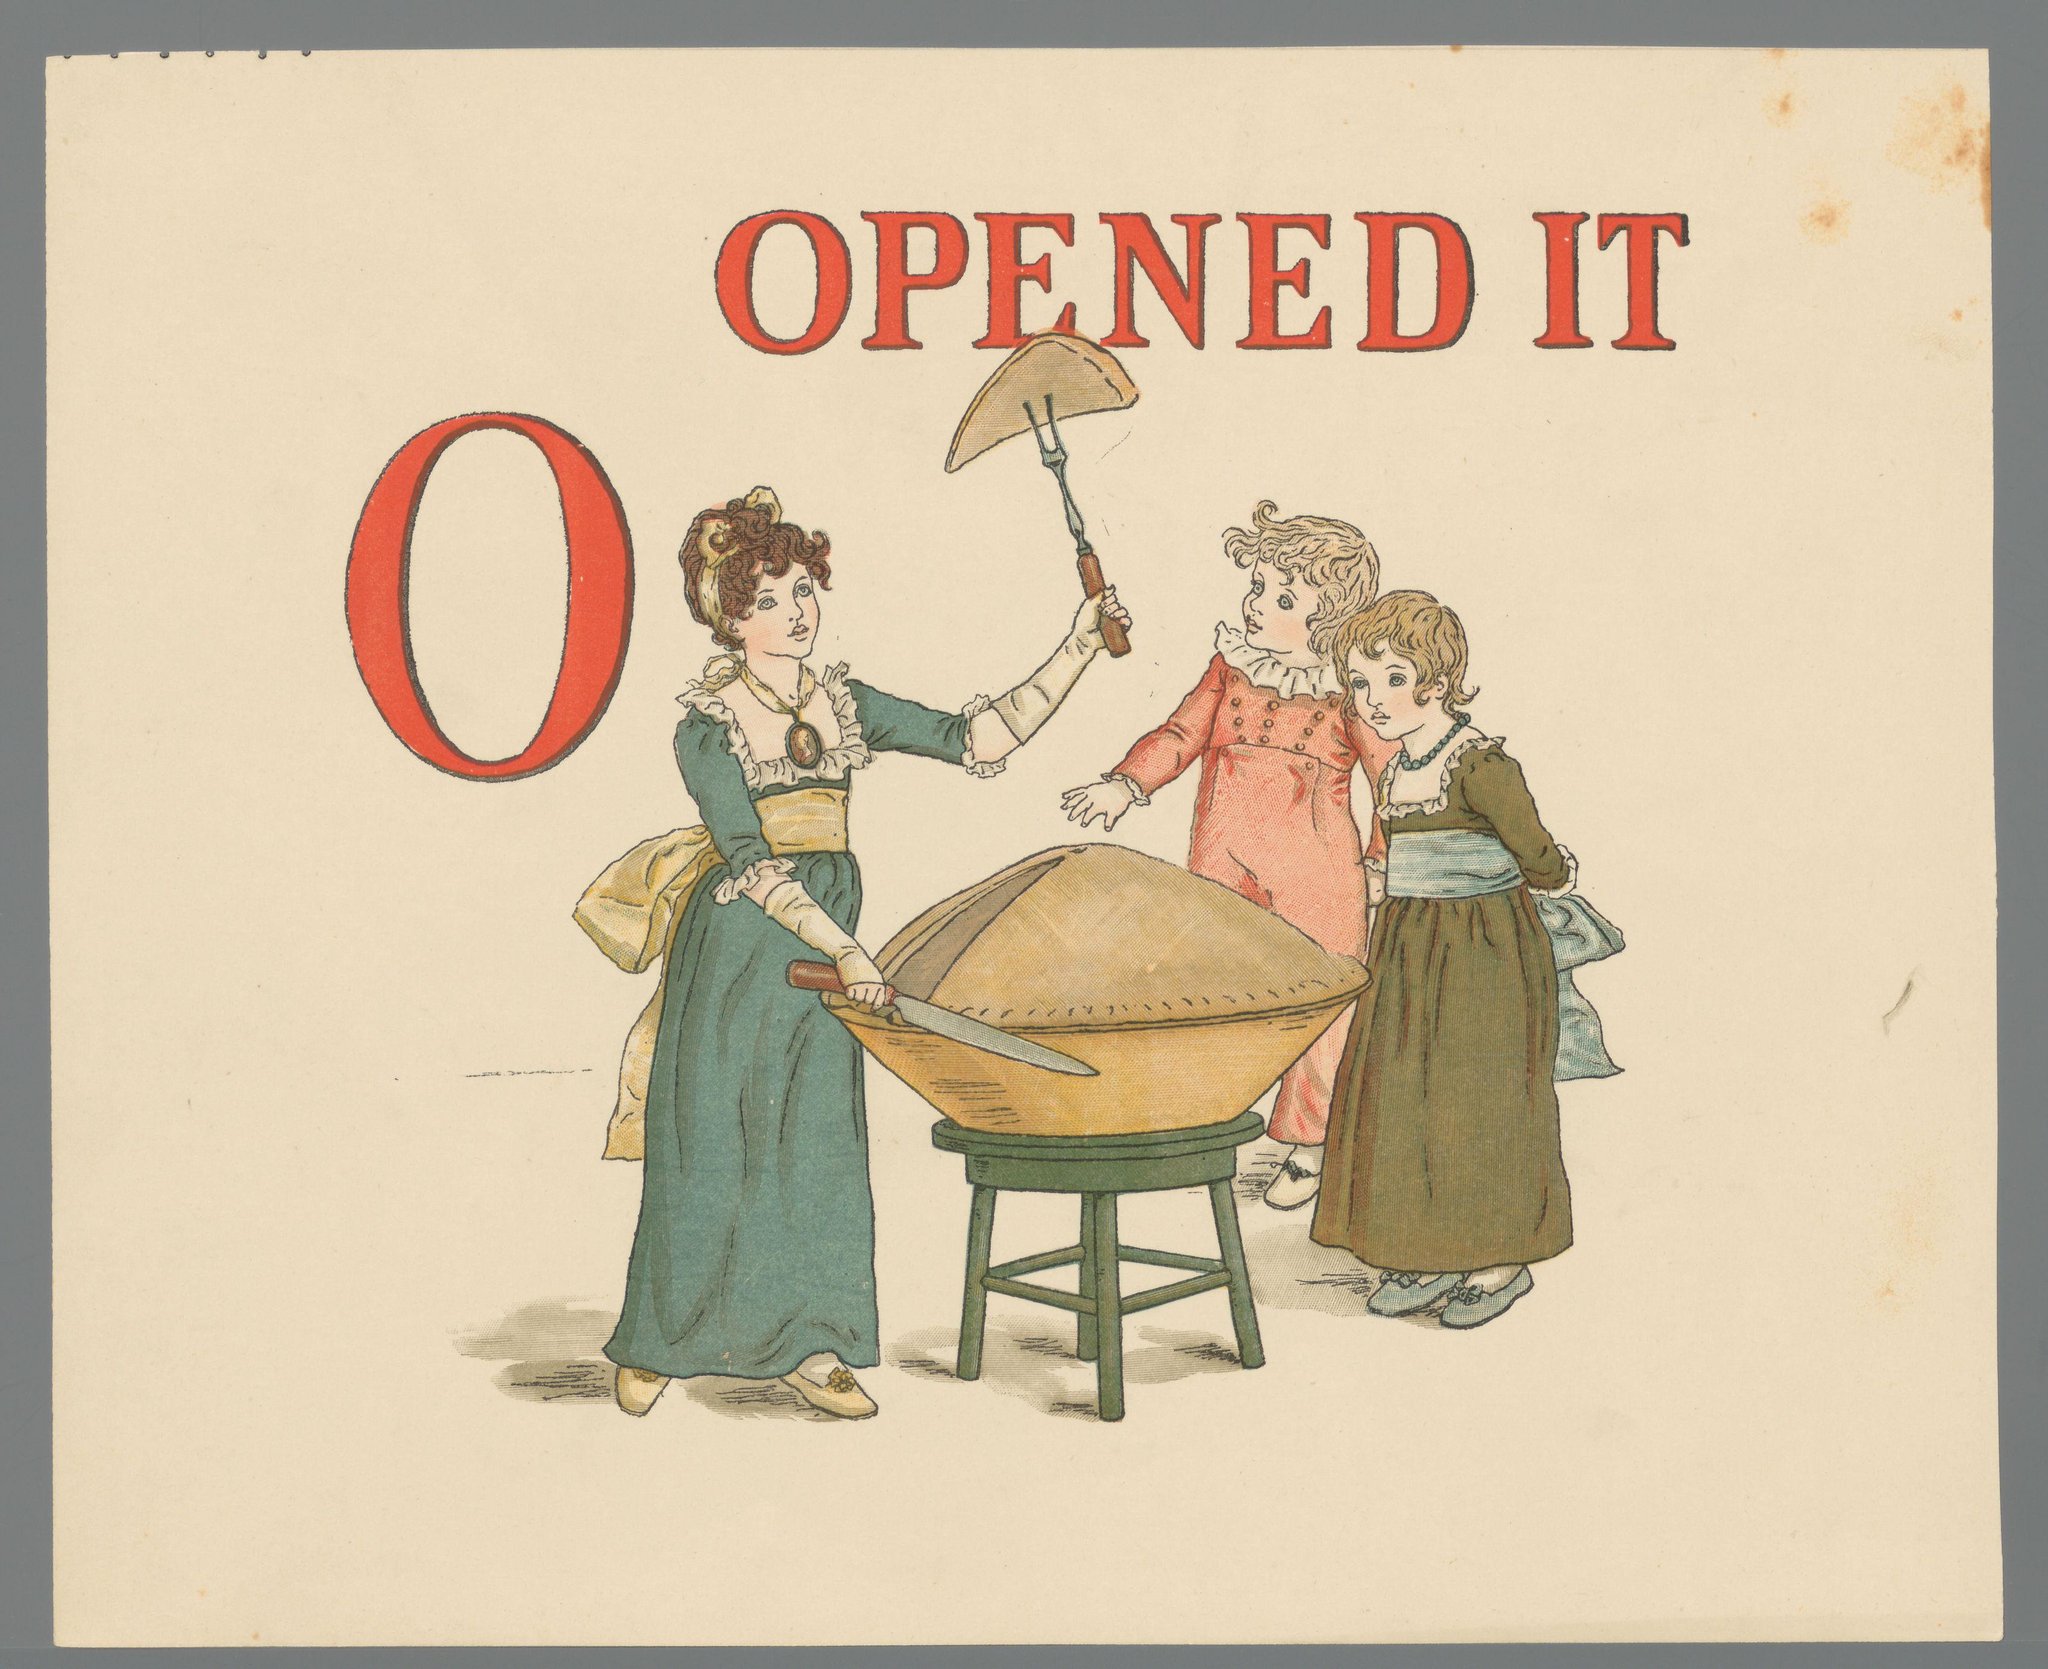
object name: book illustration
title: O opened it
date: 1886-1927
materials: paper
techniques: wood engraving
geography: london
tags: pie, child (+ three persons), preparation of food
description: Prent uit: Greenaway, Kate. A apple pie. Londen: George Routledge & Sons, 1886. Of een latere uitgave.